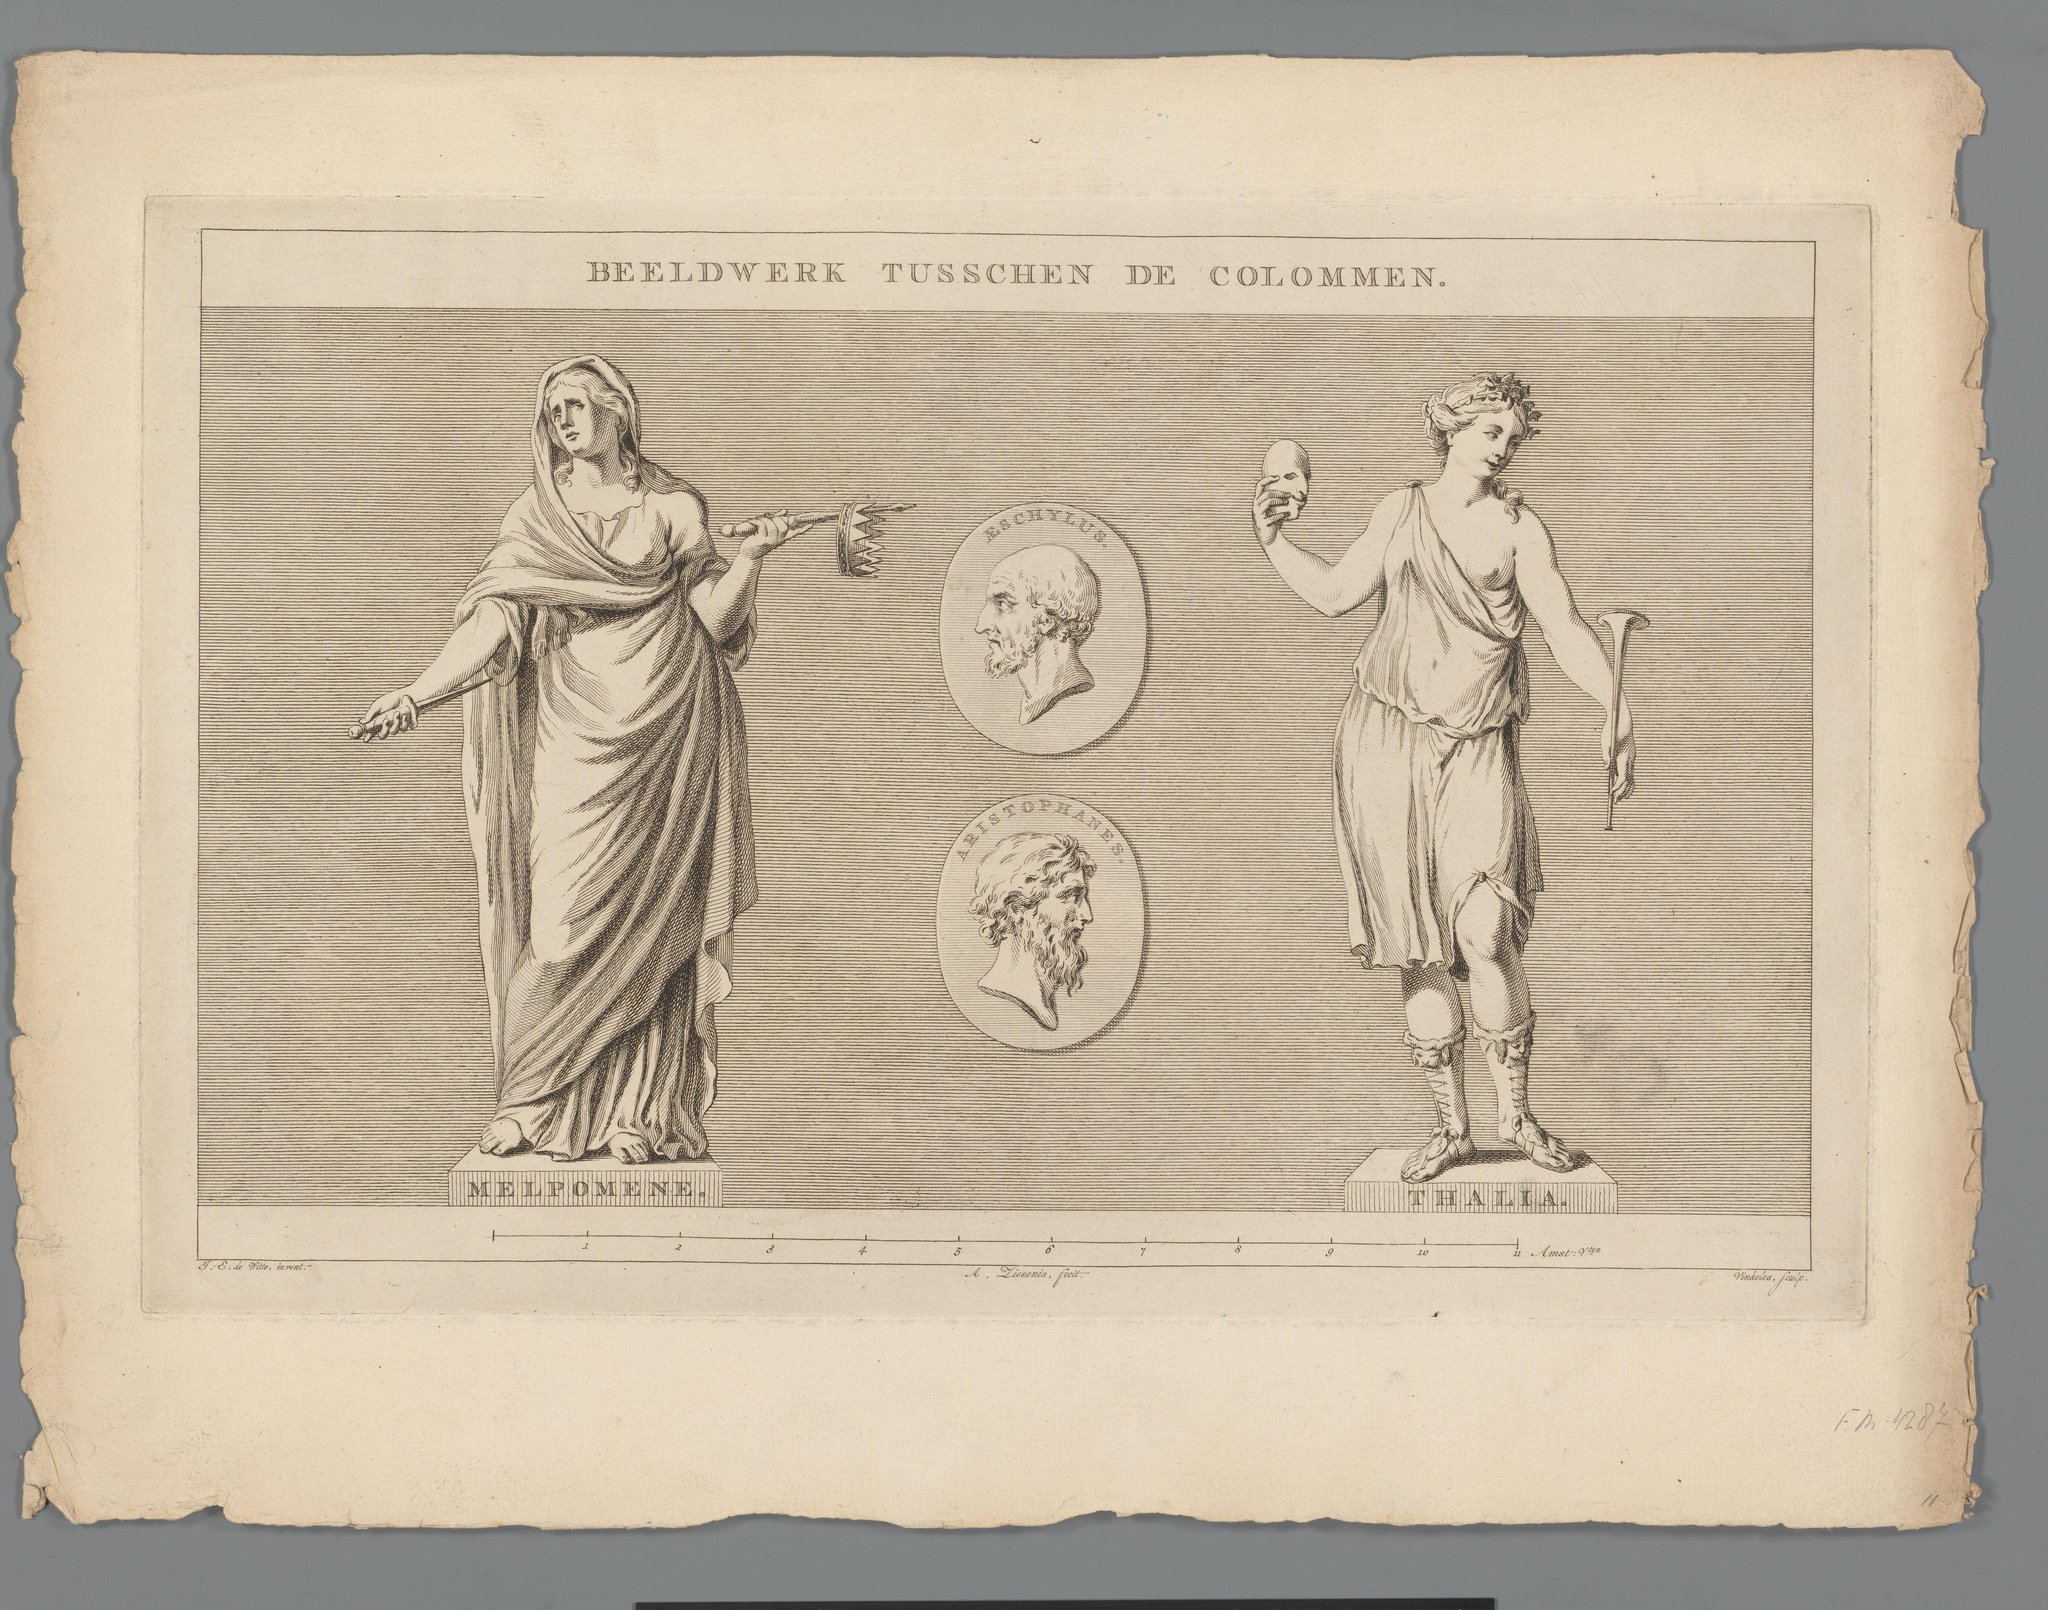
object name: print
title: Beelden van de schouwburg aan het Leidseplein te Amsterdam, 1774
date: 1774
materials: paper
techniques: etching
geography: amsterdam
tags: theatre (building), thalia (one of the muses); 'talia' (ripa), melpomene (one of the muses); 'melpomene' (ripa), amsterdam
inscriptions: date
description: Links een beeld van Melpomene, in het midden twee portretten van Aeschylus en Aristopanes, rechts een beeld van Thalia.